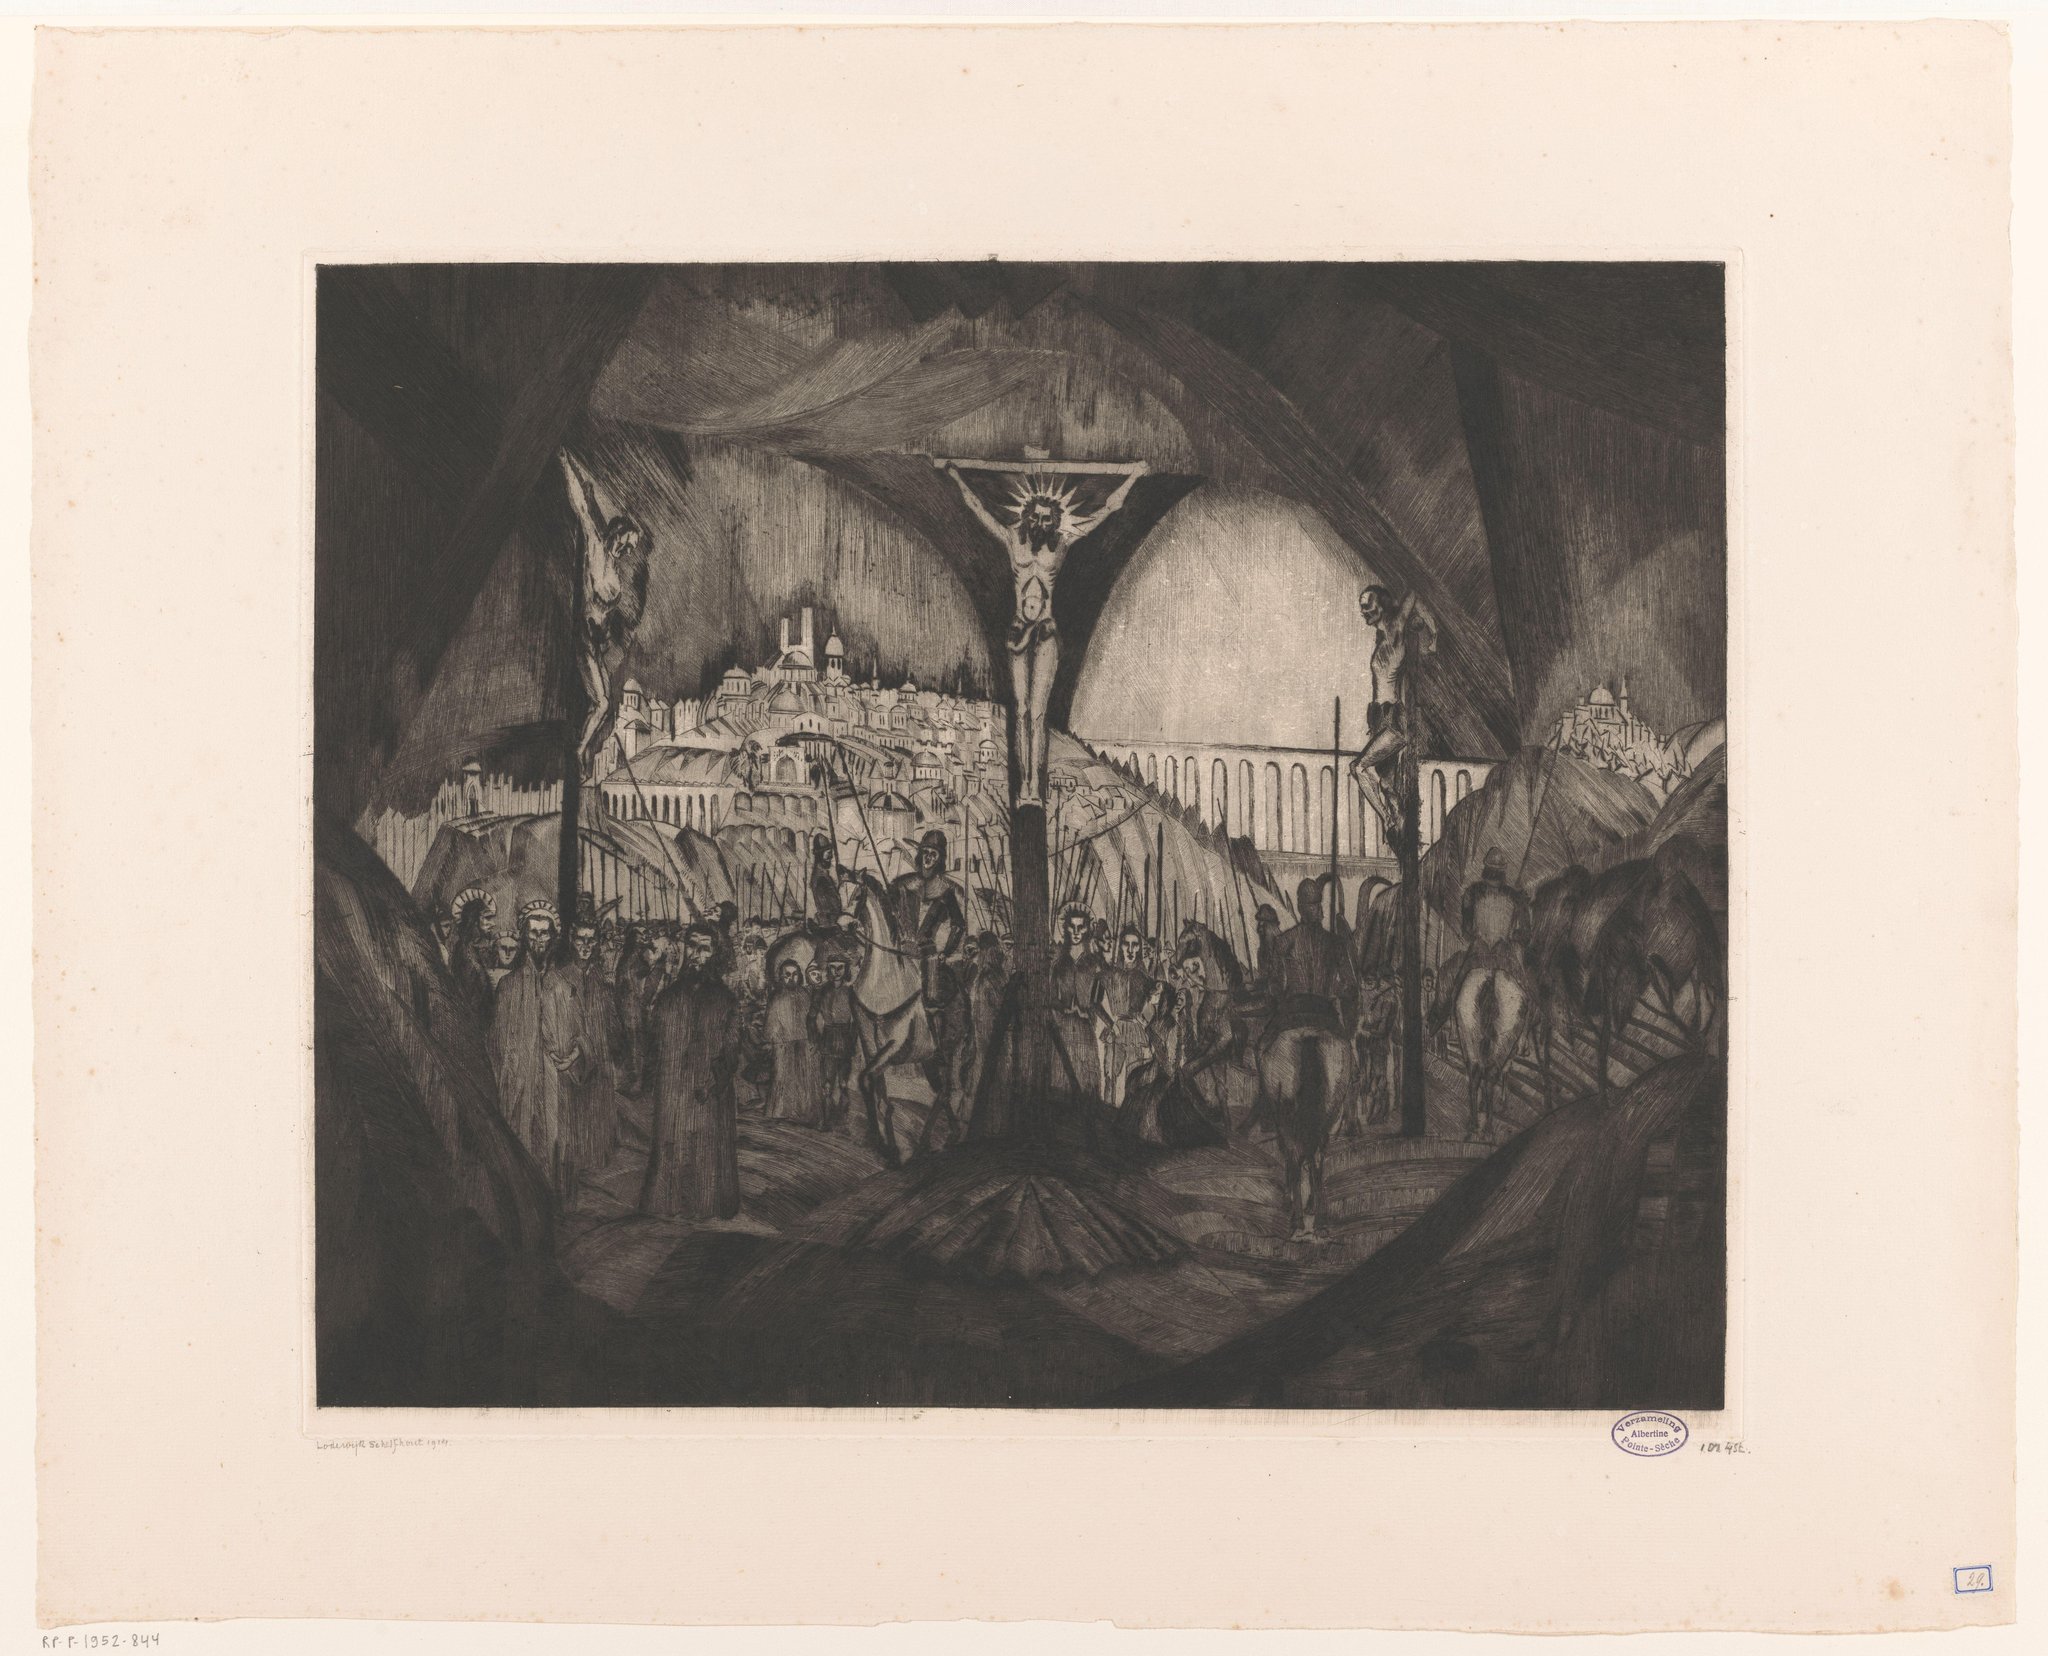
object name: print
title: Golgotha I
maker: lodewijk schelfhout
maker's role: draughtsman, print maker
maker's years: 1881-1943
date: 1914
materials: paper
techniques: drypoint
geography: netherlands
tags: city-view, and landscape with man-made constructions, the crucifixion of christ: prelude to christ's death on the cross (matthew 27:34-44; mark 15:23-32; luke 23:33-43; john 19:18-24)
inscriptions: collector's mark: Lugt 2228, collector's mark: Lugt 2760, collector's mark: Lugt 5i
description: Christus en de twee misdadigers aan het kruis op de heuvel Golgota. Onder hen een menigte mensen en ruiters te paard. Op de achtergrond twee gedeelten van een stad die onderling verbonden zijn met een brug.